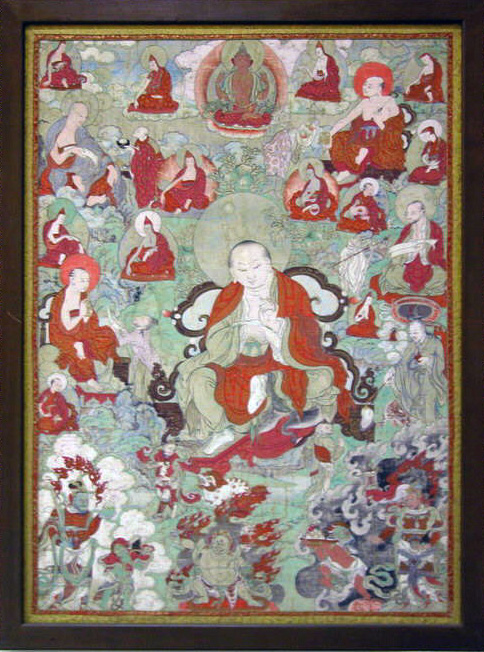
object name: triptych panel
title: Luohan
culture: chinese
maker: unidentified artist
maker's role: artist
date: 1368-1644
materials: linen, panel, watercolor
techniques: painting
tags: men,buddhism